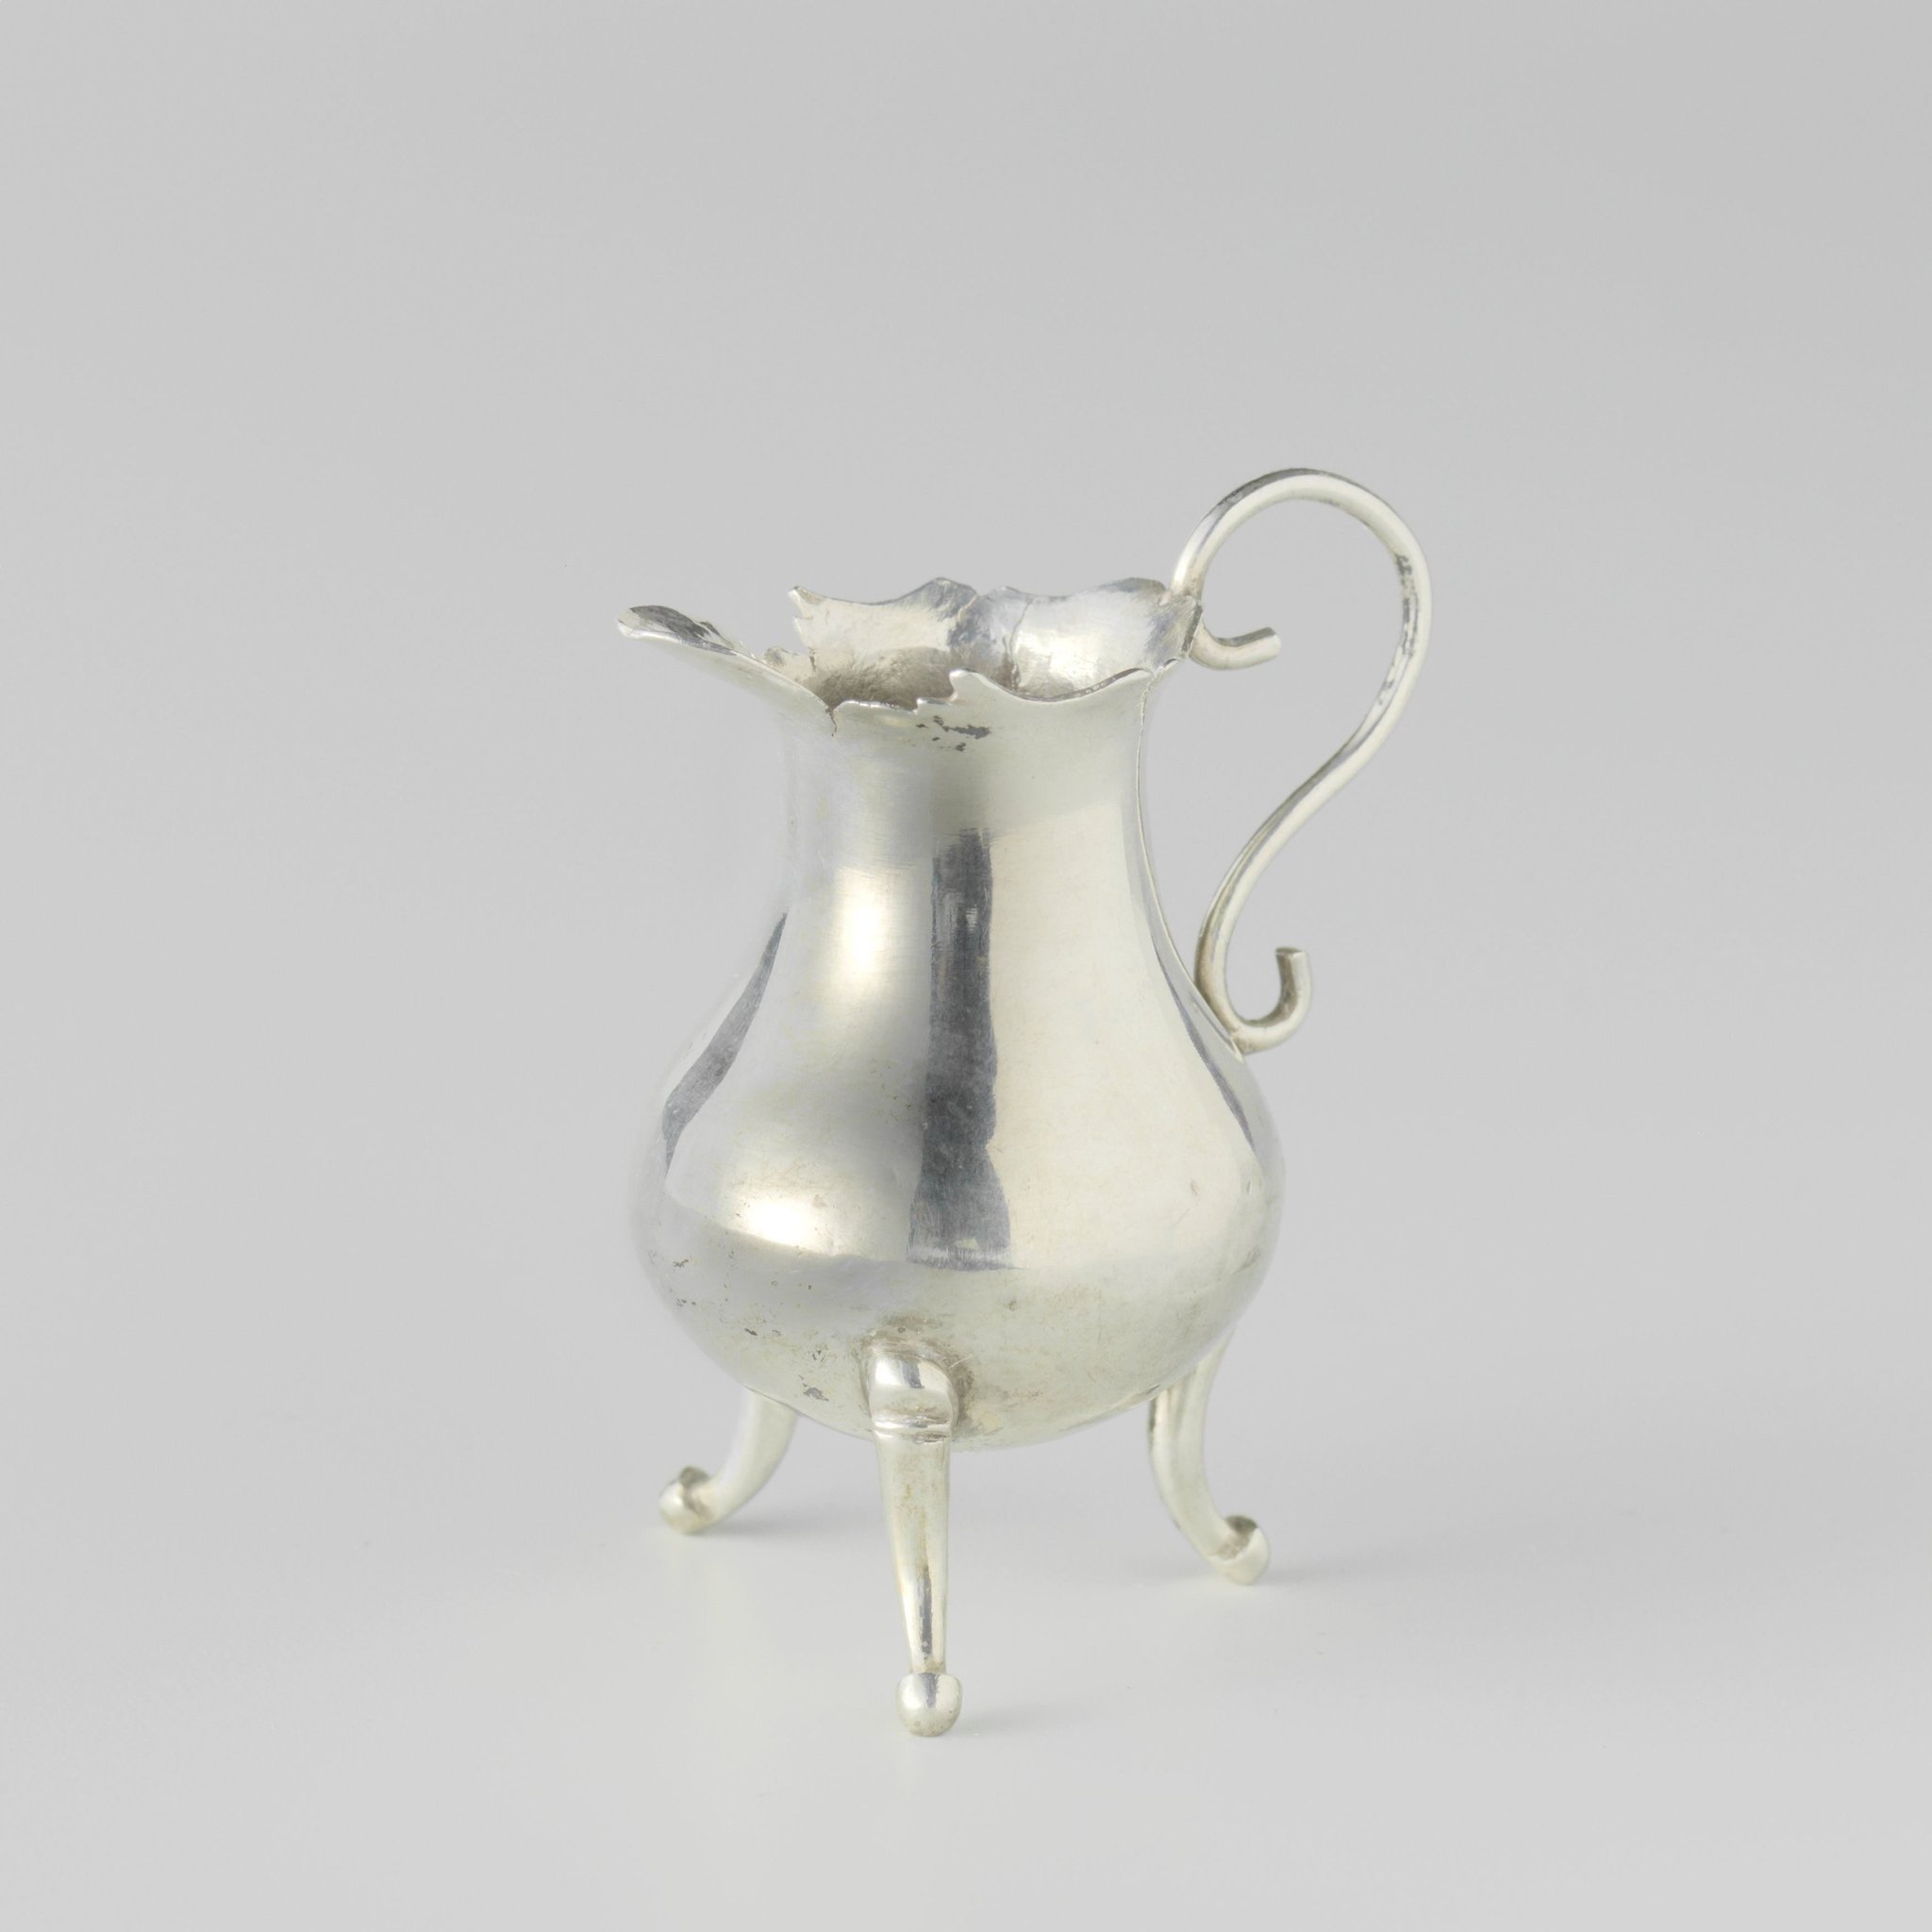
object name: miniature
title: Melkkan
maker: daniël van strant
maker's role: silversmith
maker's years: 1694-1756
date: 1748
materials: silver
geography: amsterdam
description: Peervormige melkkan op drie brede, platte, naar buiten gebogen poten. Het handvat is S-vormig en de bovenrand van de kan is gekarteld. De melkkan is gemerkt: stk.= Amsterdam, jrl.= O (1748) en mt.= toegschreven aan Daniel van Strant.